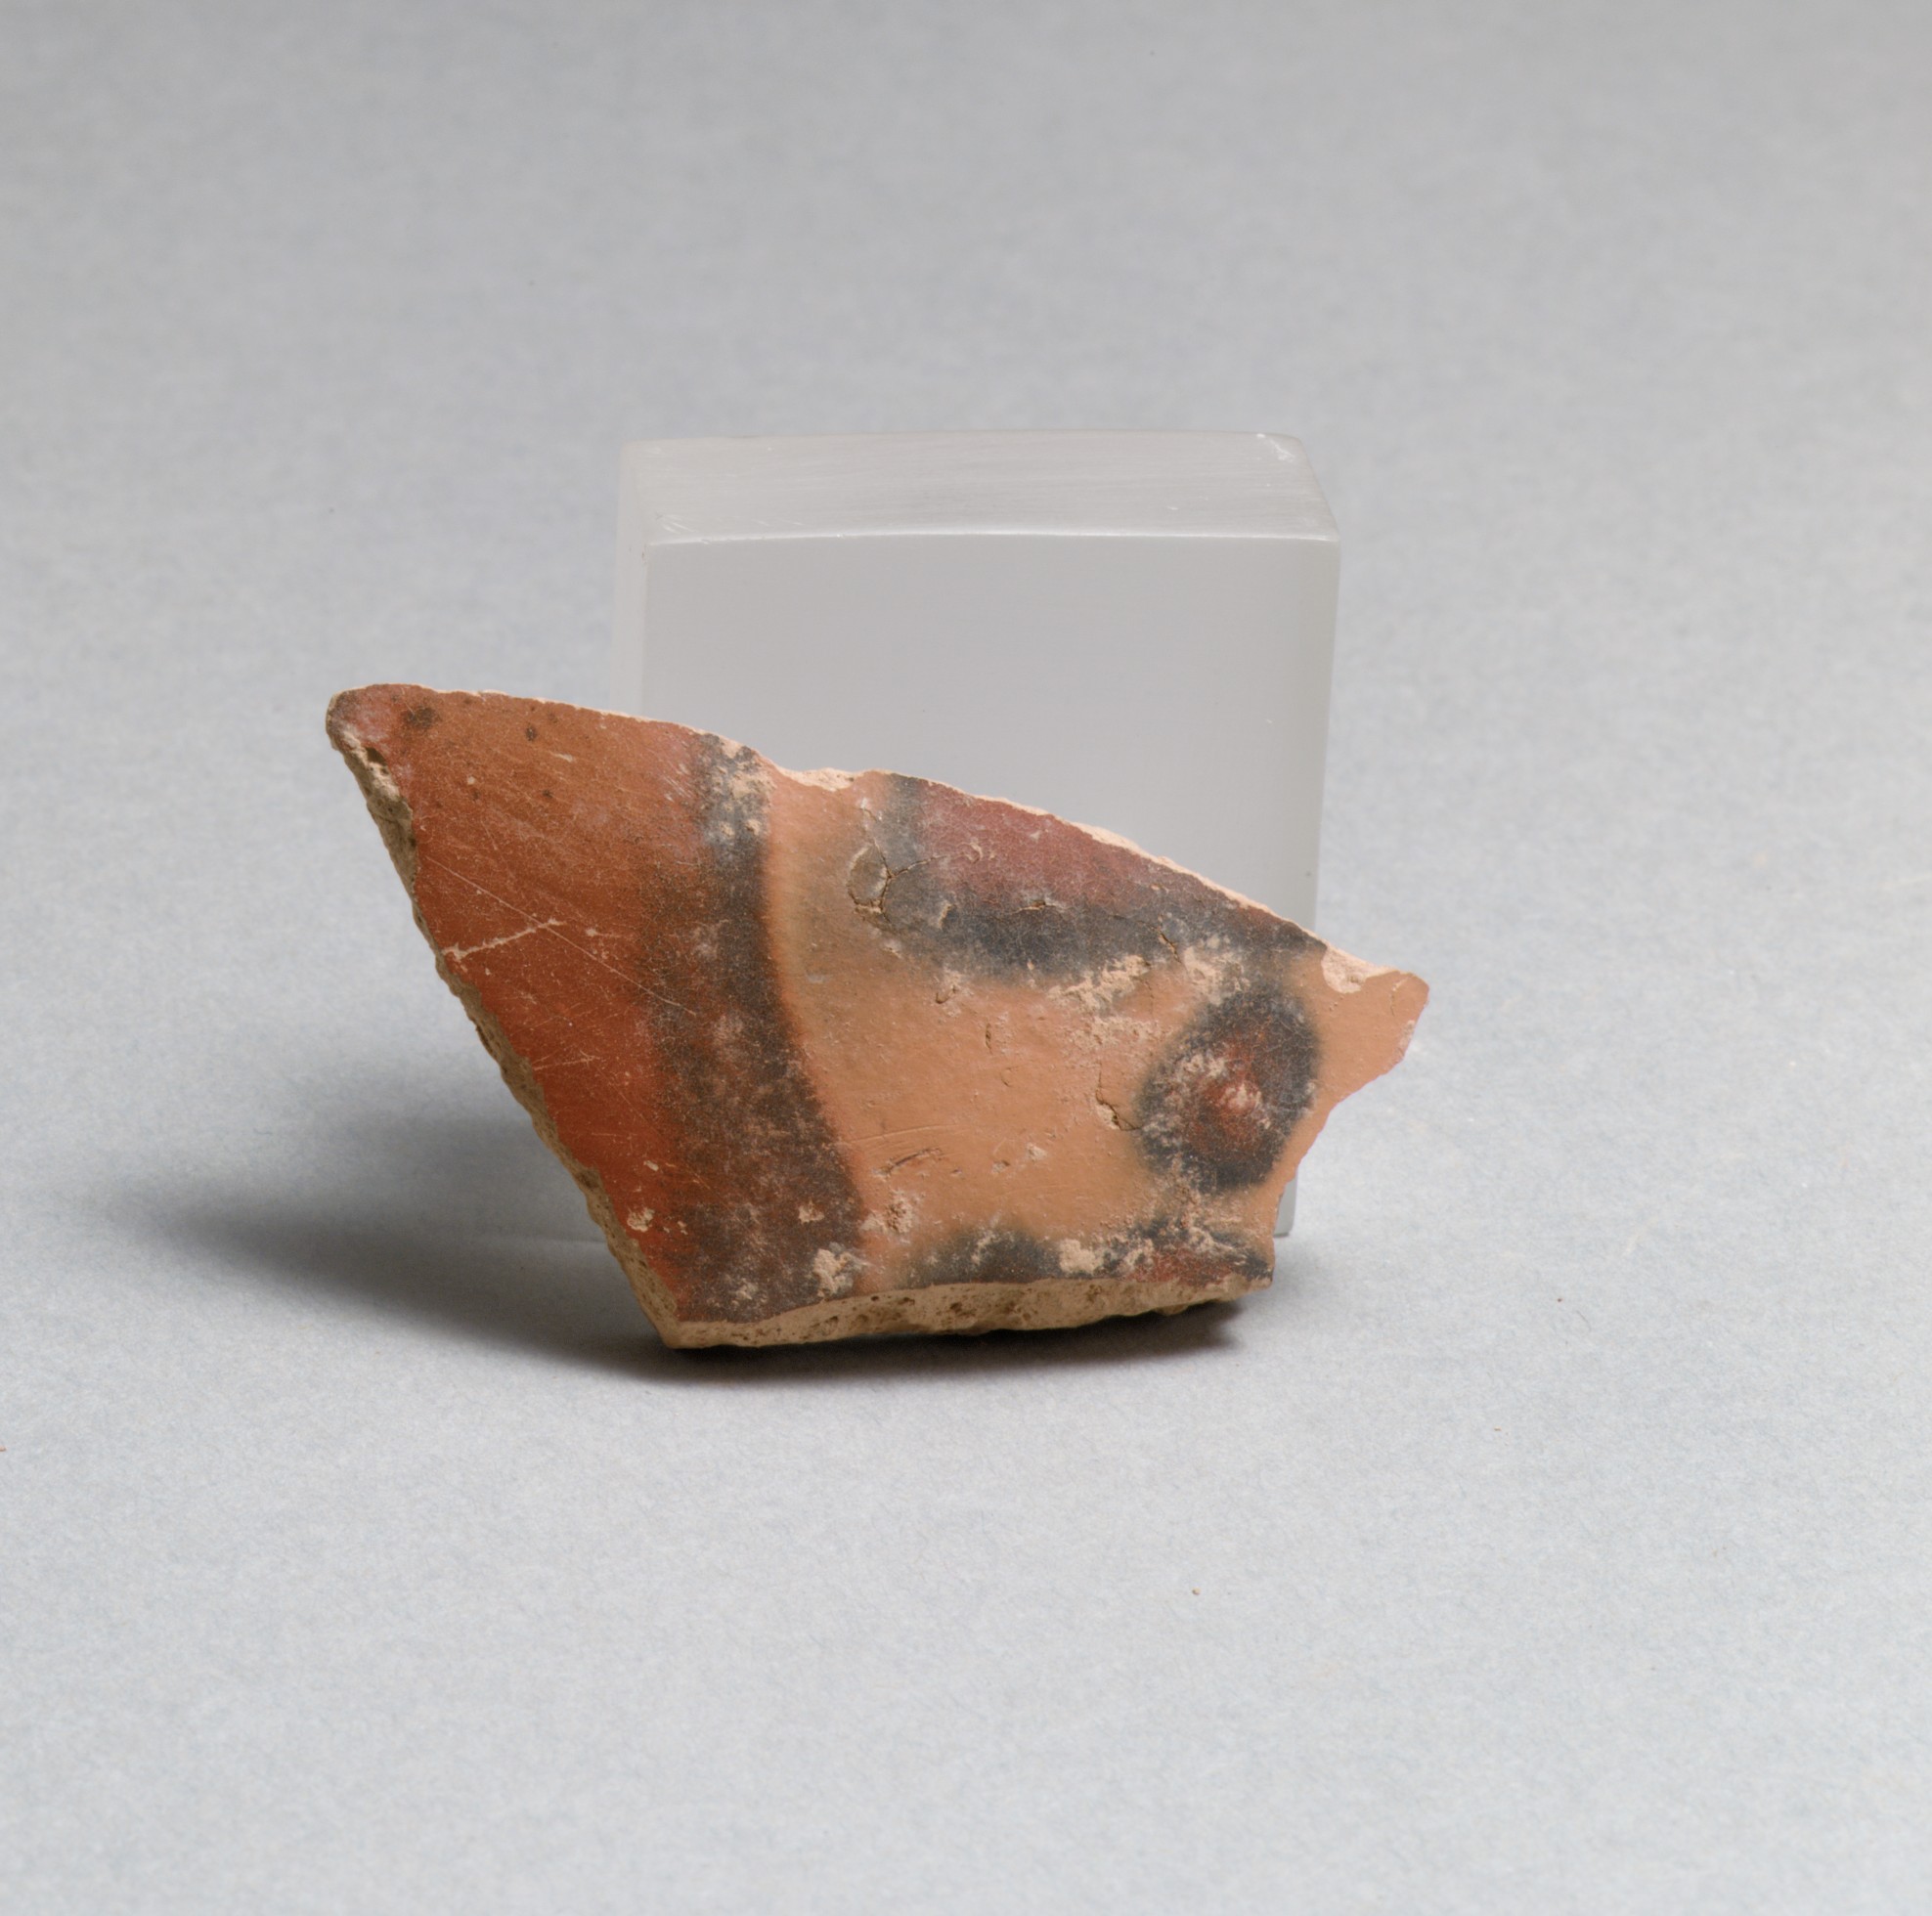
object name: vase fragment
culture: minoan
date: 2600-2000 BCE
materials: terracotta